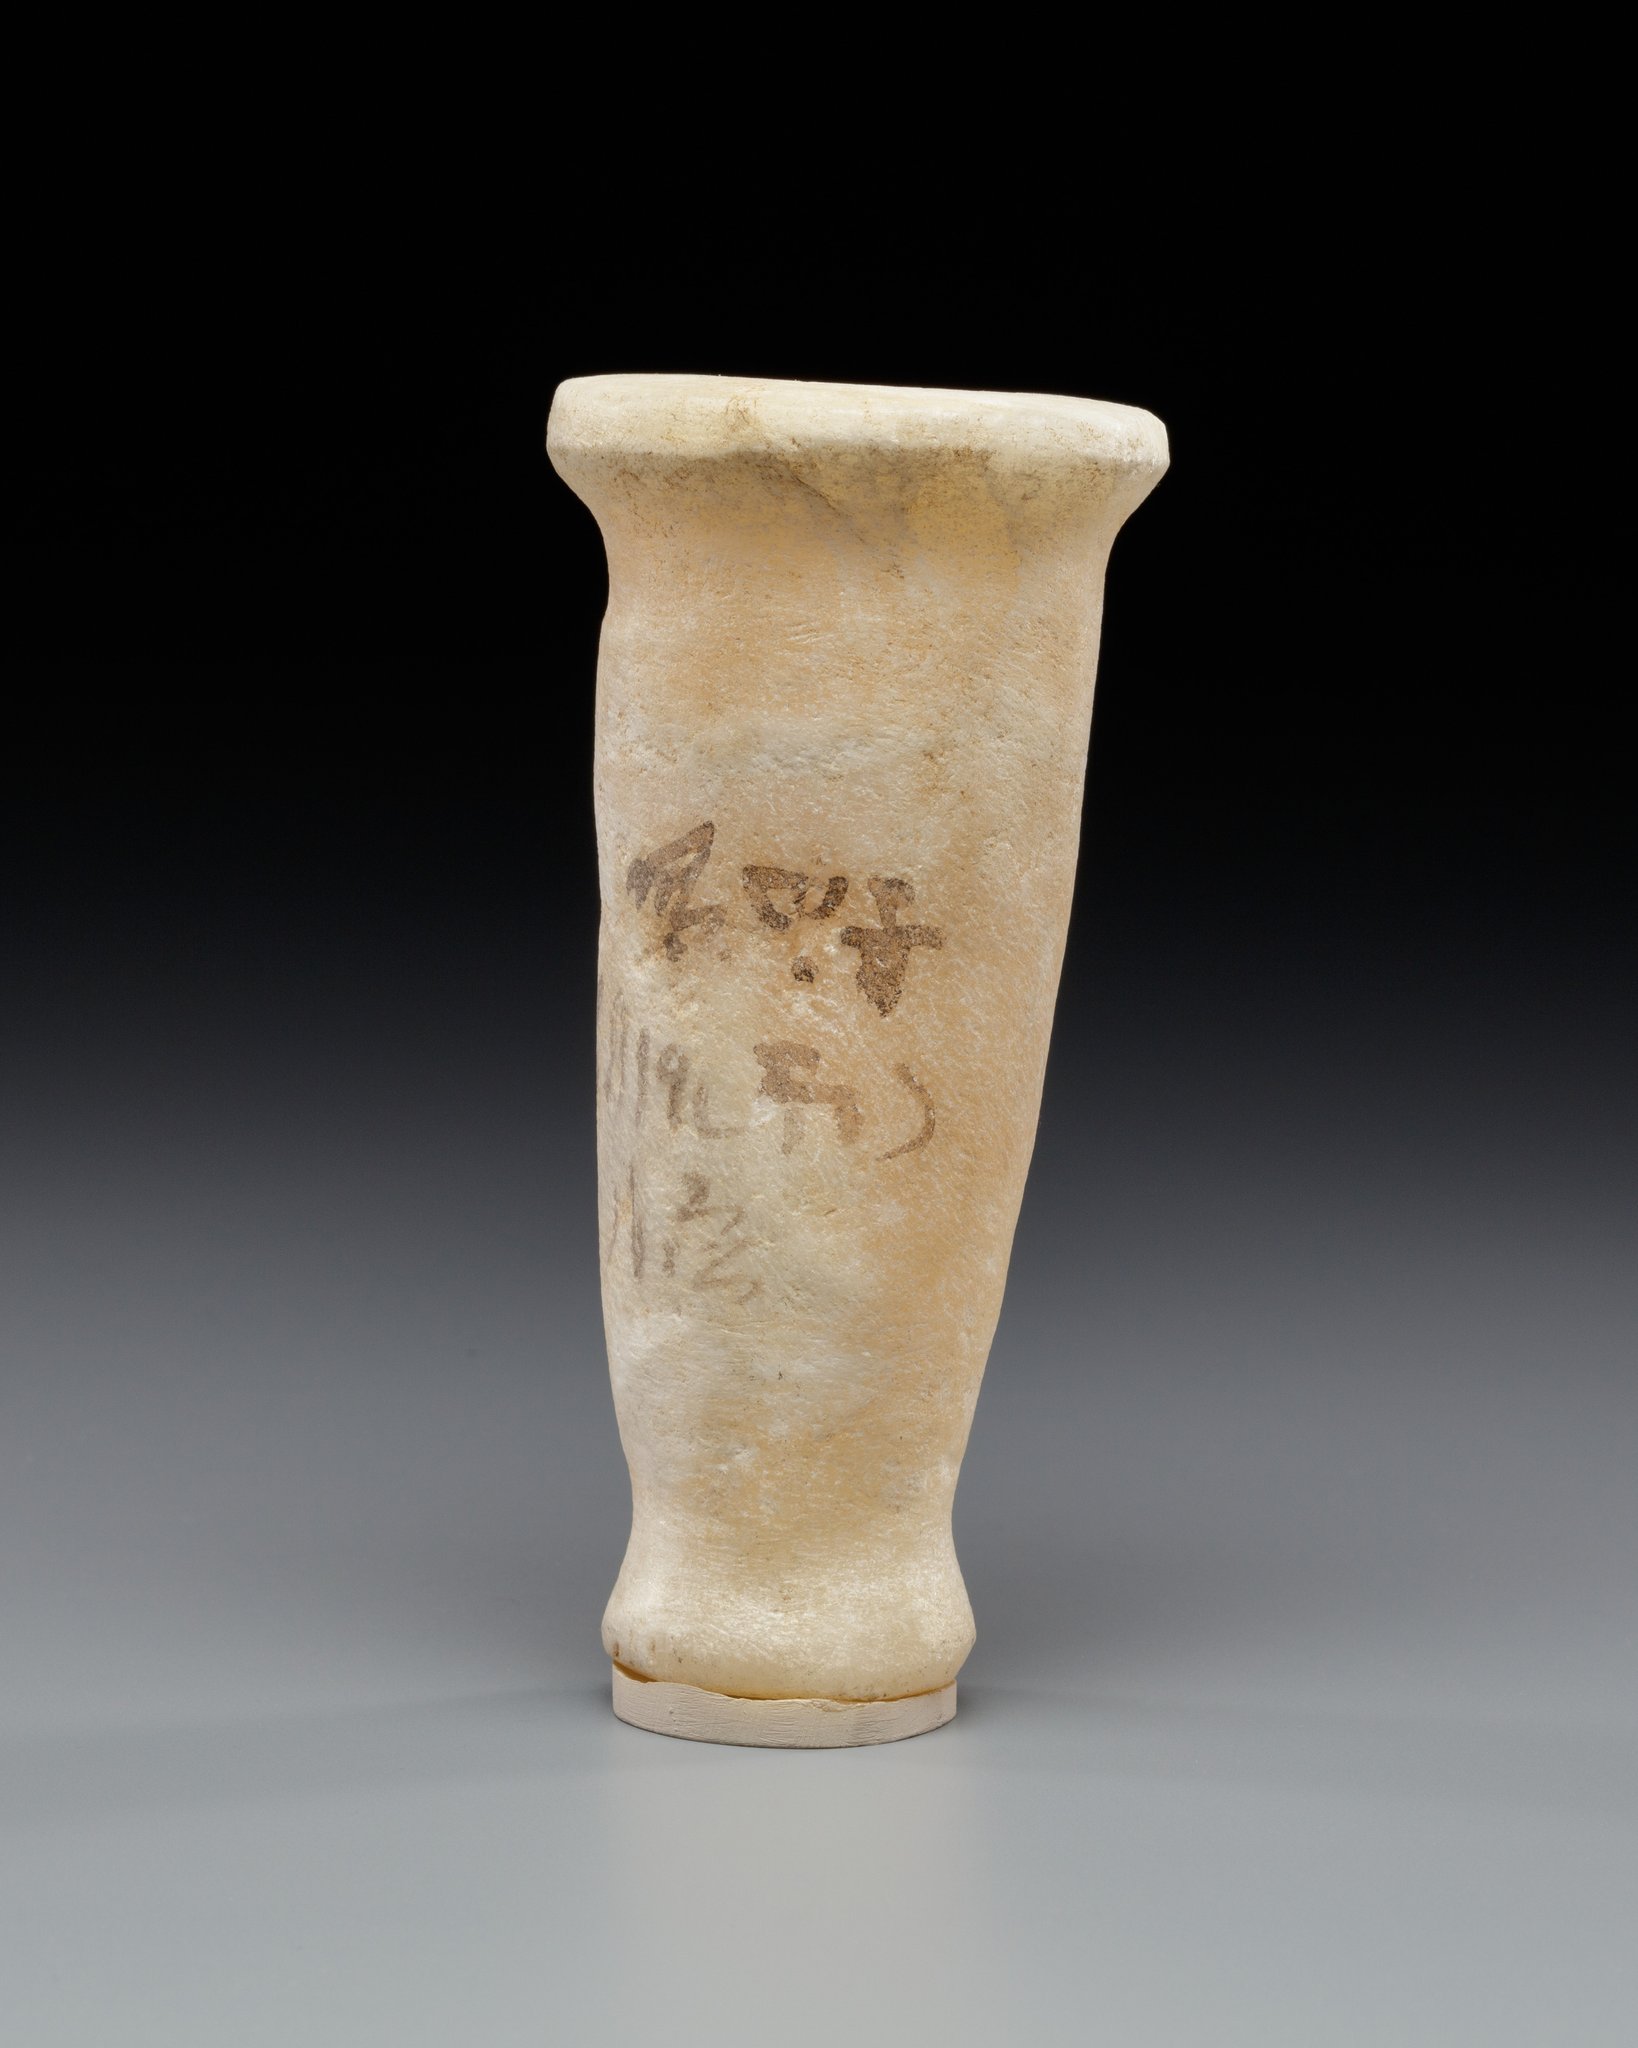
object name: model, ointment jar, foundation deposit, hatshepsut merytre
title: Model Jar from a Foundation Deposit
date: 1479-1425 BCE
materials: paint, stone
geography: egypt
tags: hieroglyphs